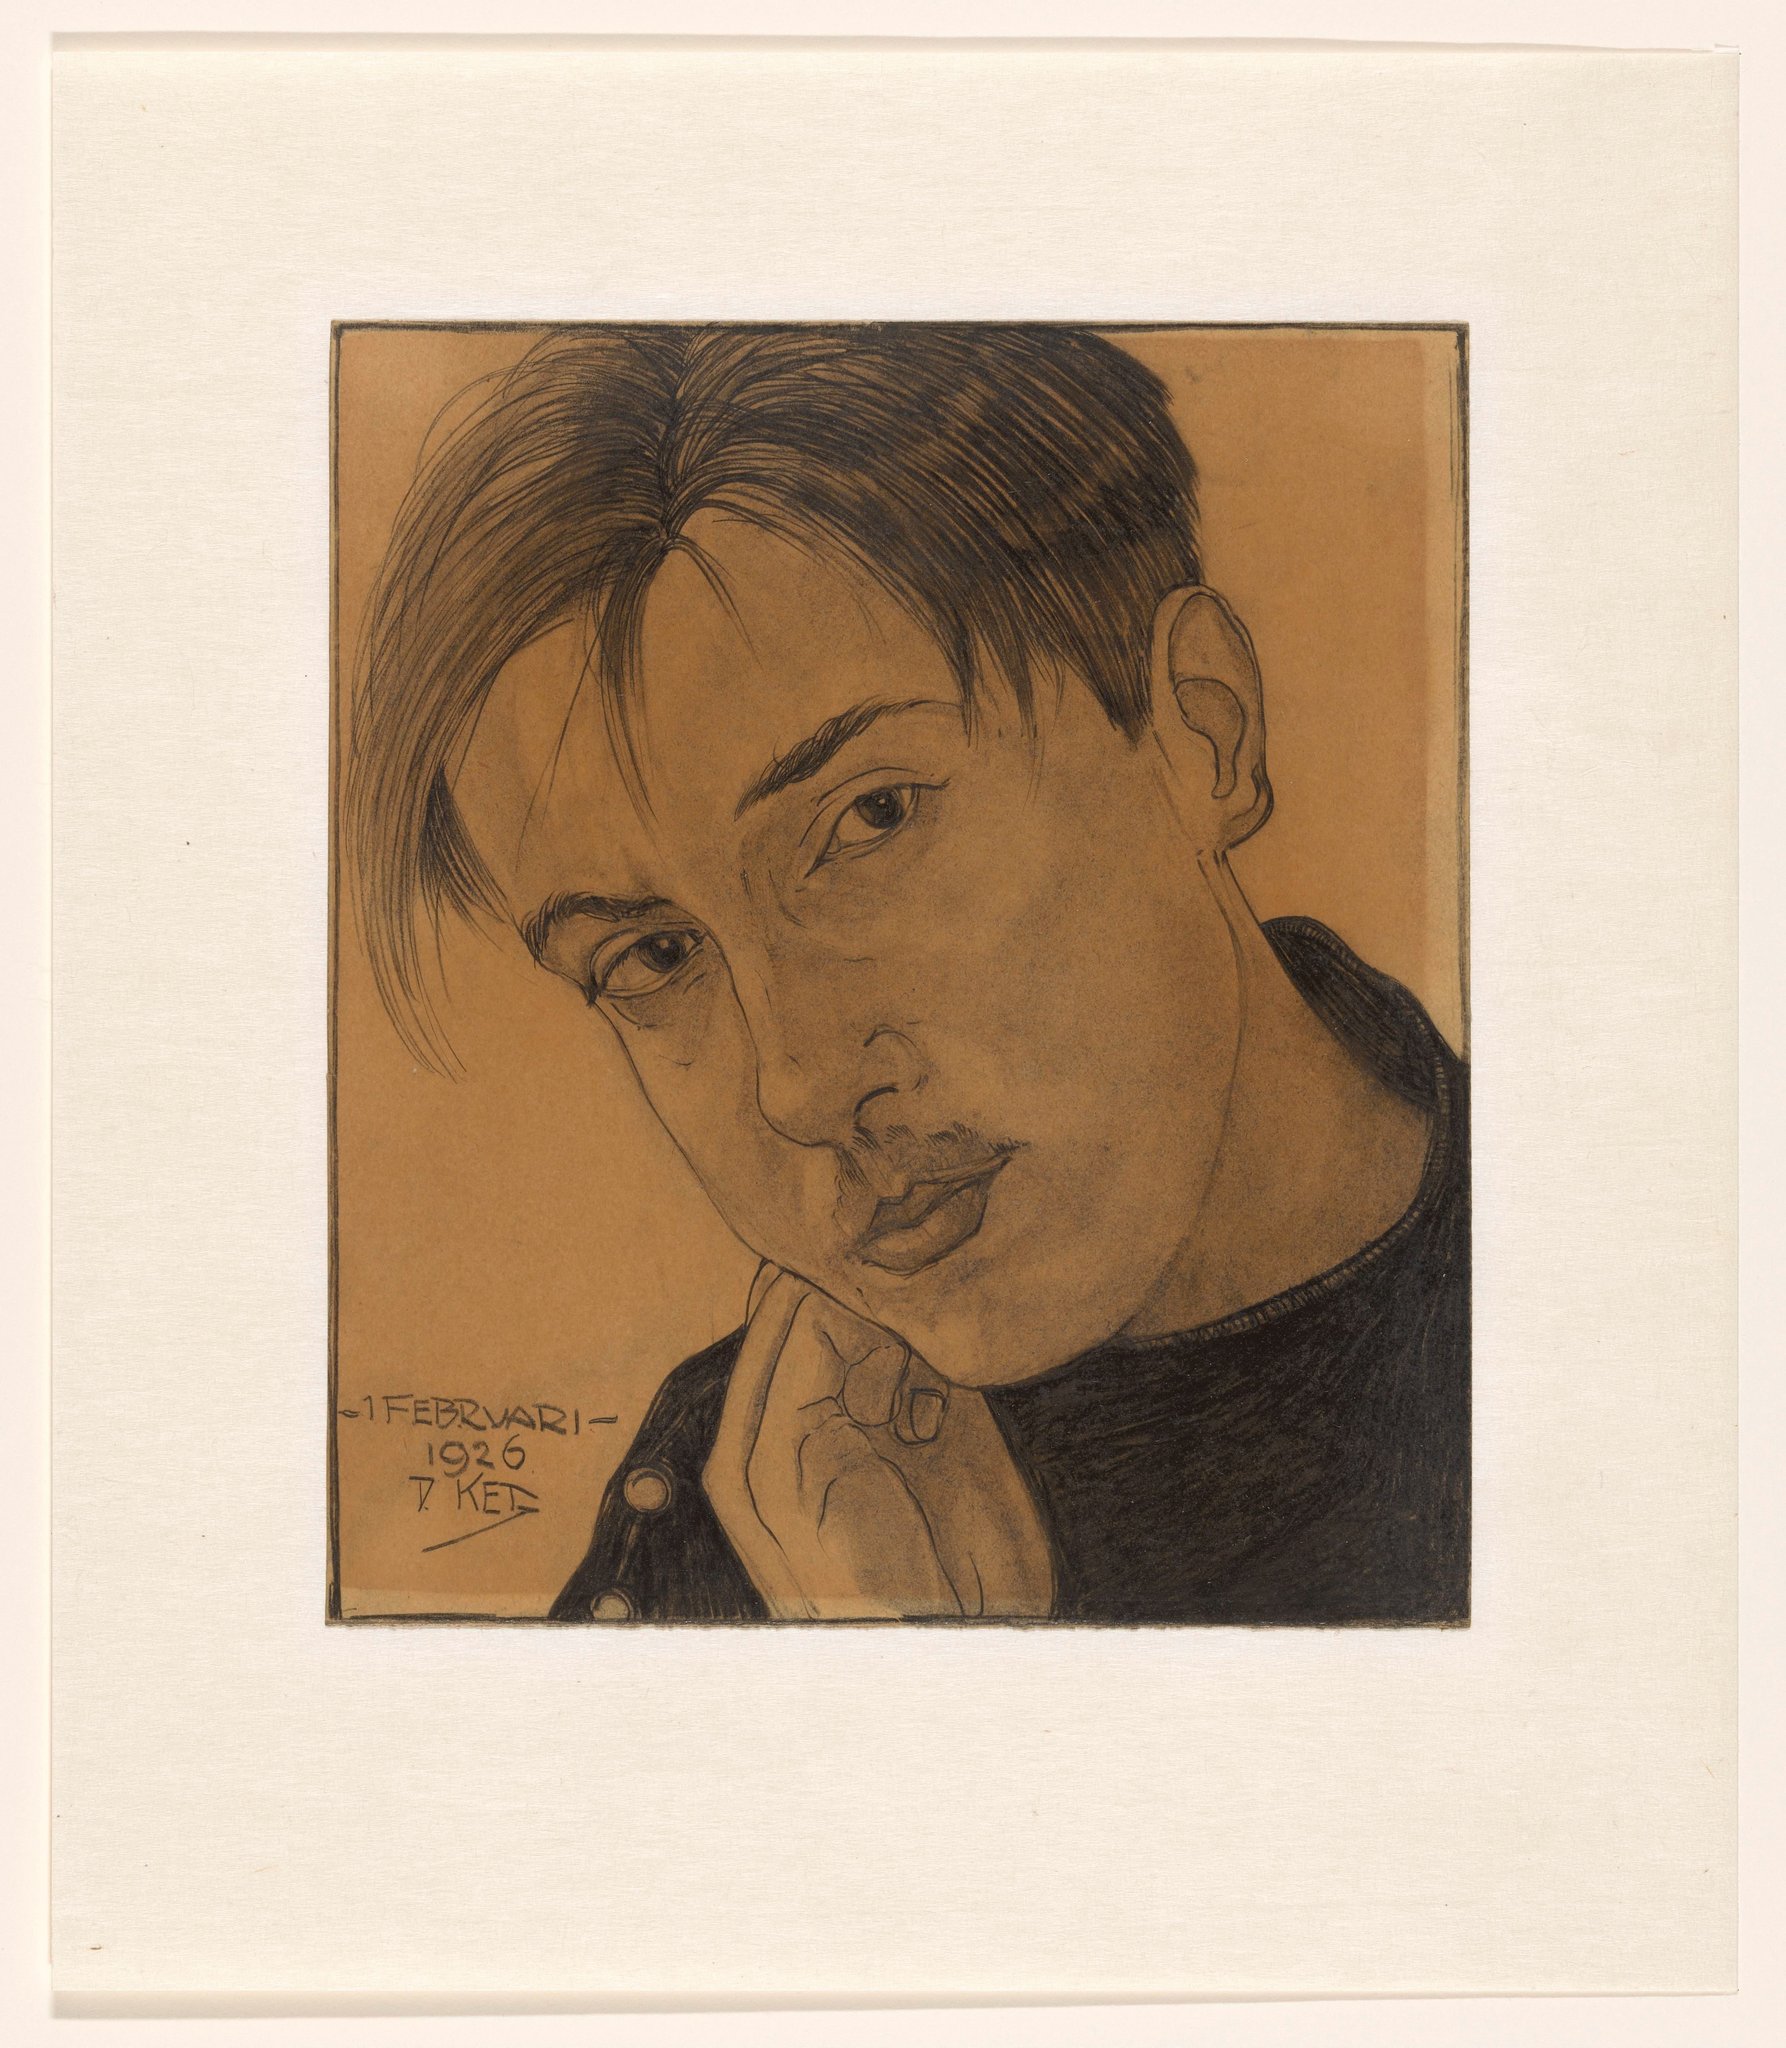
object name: drawing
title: Zelfportret (met hand)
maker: dick ket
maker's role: draughtsman, print maker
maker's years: 1902-1940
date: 1926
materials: chalk, paper, pencil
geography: bennekom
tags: den helder, print maker, draughtsman, dick ket, historical persons, portrait, self-portrait of artist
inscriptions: signature and date: ‘- 1 FEBRUARI - 1926 D. KET’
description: Portret van de kunstenaar met het hoofd iets scheef, piekerig haar over zijn voorhoofd, zijn kin steunend op zijn rechterhand, gekleed in een zwarte coltrui. Haren, ogen, neus, mond en hand zijn met zwarte strakke lijnen getekend over een schetsmatig opgezette tekening.